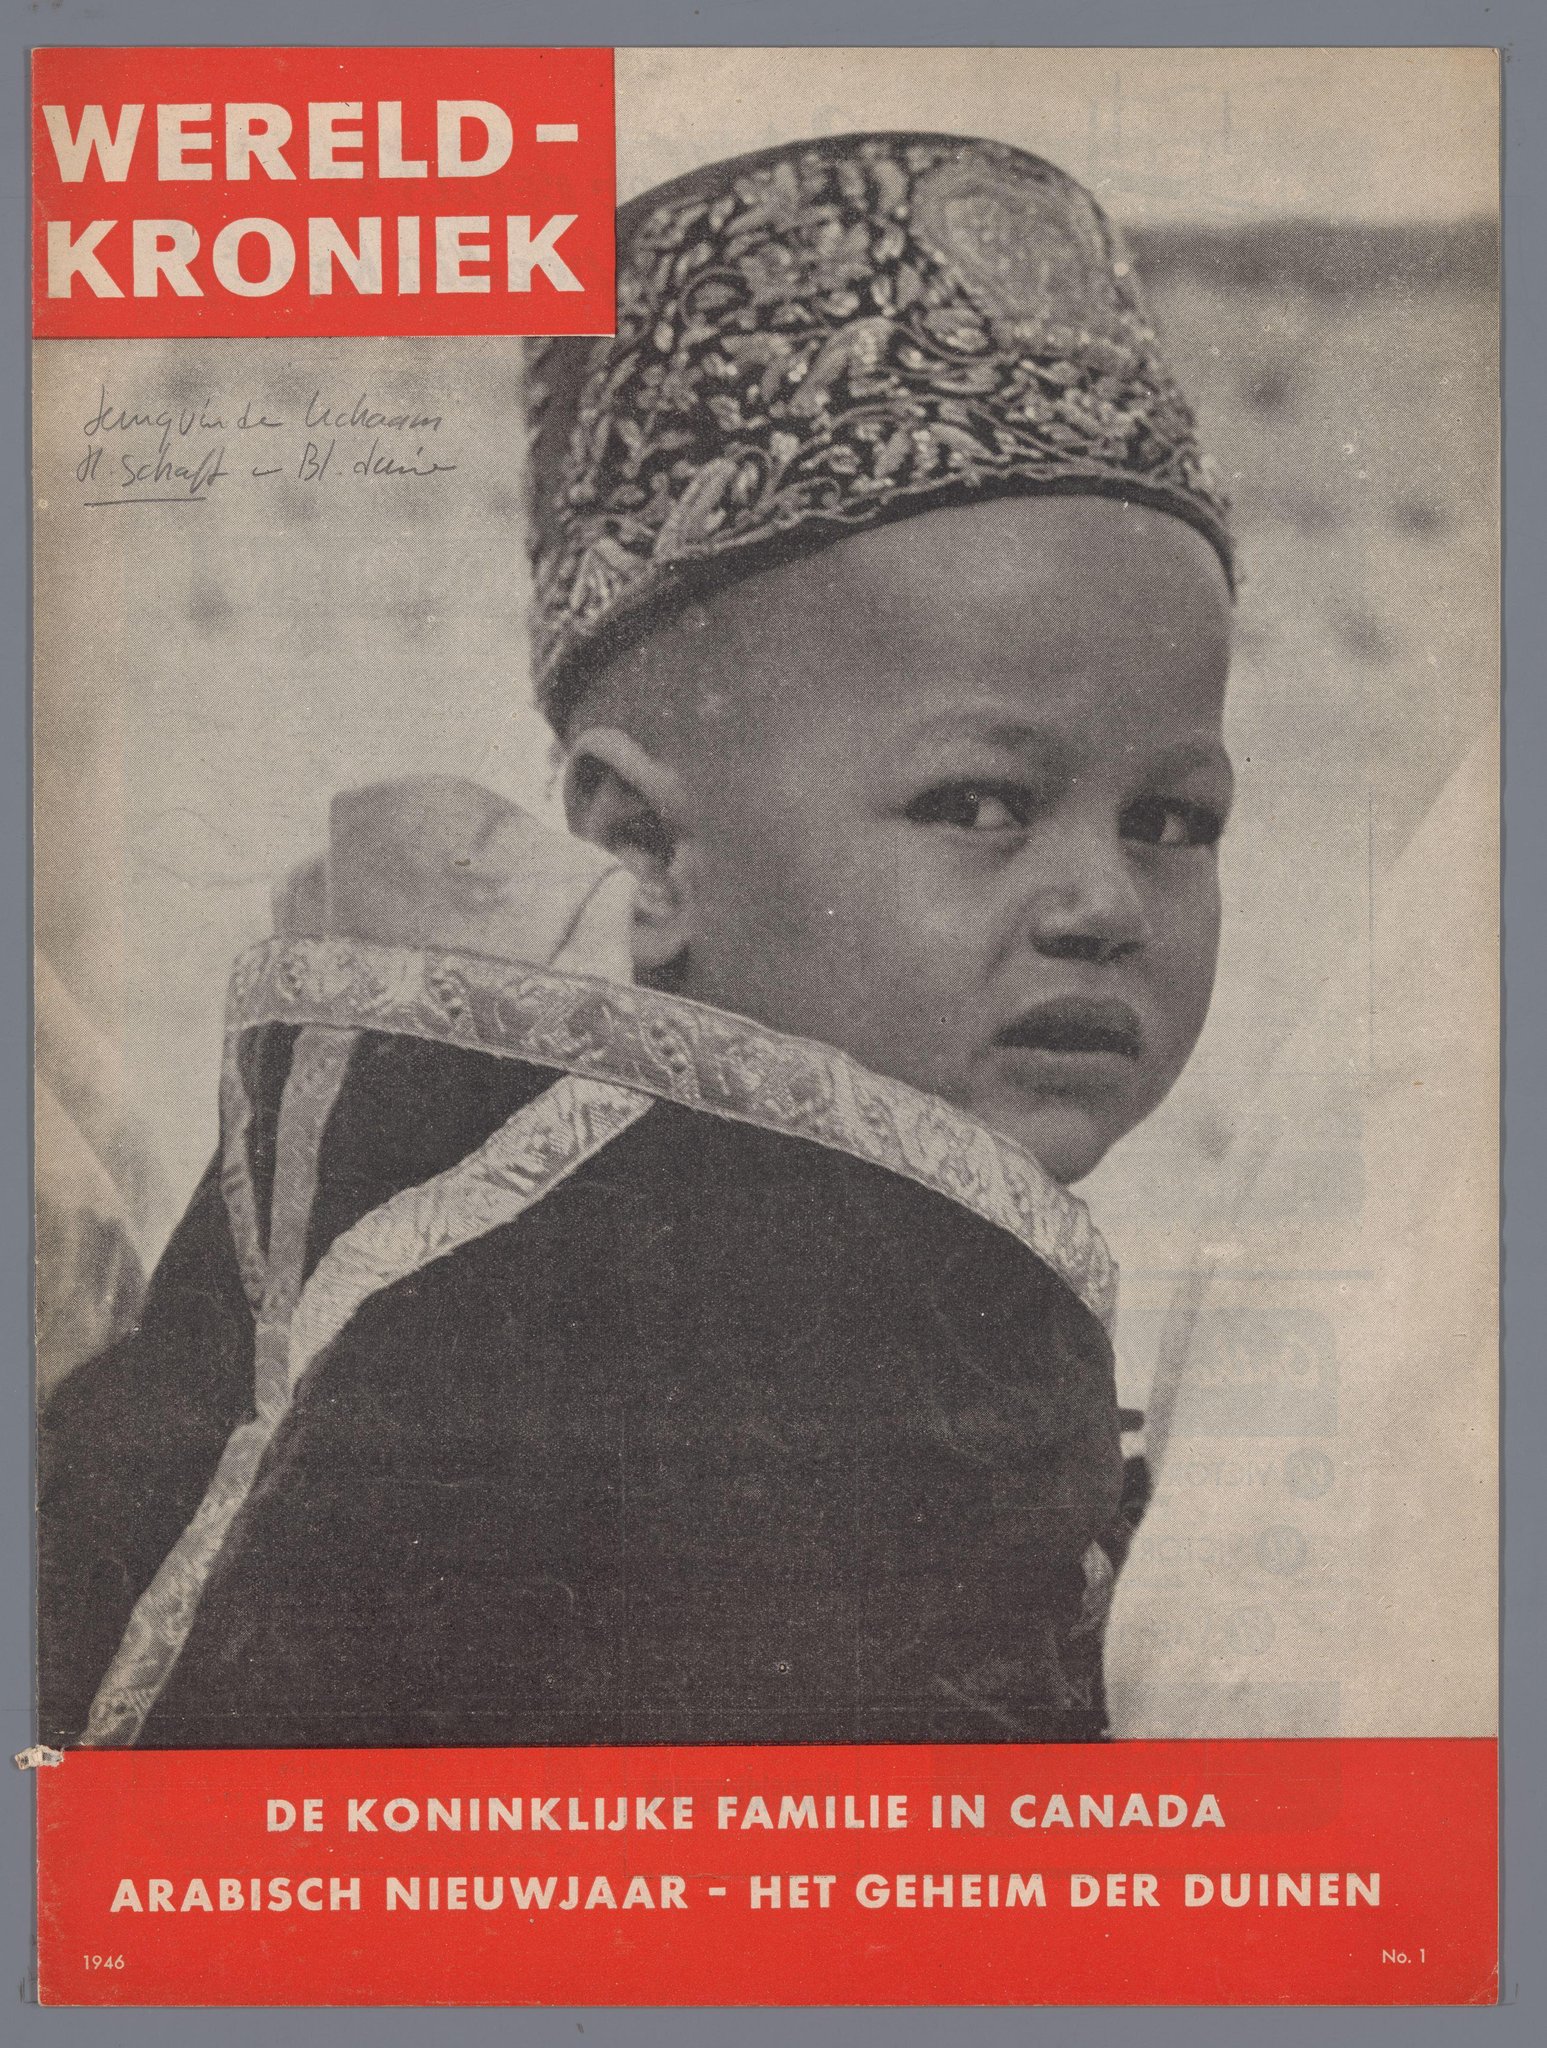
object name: magazine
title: Wereld-kroniek, 5 januari 1946 (49e jaargang)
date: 1945-1946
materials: paper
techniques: printing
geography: the hague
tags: tweede wereldoorlog, bevrijding van nederland (1945)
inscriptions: date: ‘5 januari 1946’, inscription: ‘WERELD-KRONIEK’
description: Tijdschrift met op omslag een zwart-wit foto. R.b. een rood fond waarop in witte letters het opschrift, onderaan eveneens een rode baan met daarop titel van hoofdonderwerp per aflevering. Ongeveer 14 pagina's. Nummer behoort tot 49e jaargang. Inhoud: algemeen nieuws van hele wereld, met foto's en advertenties.